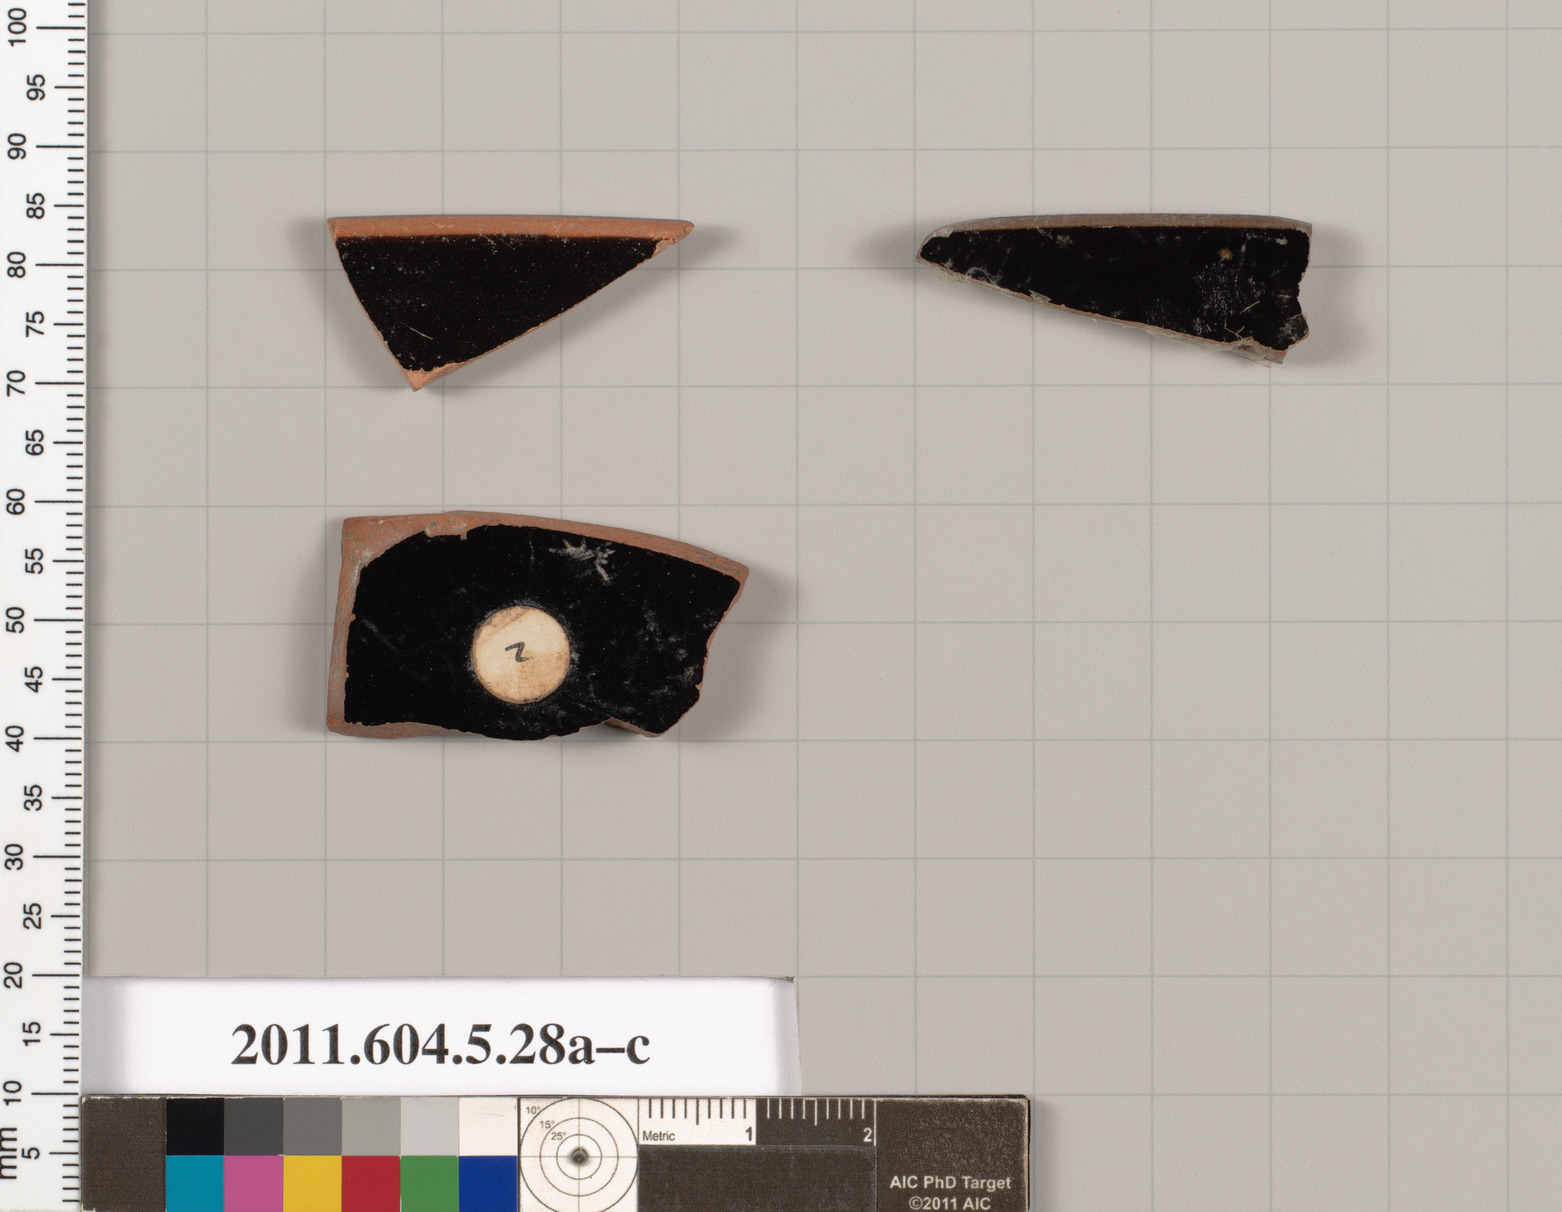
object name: kylix fragment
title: Terracotta fragments of kylikes (drinking cups)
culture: greek, attic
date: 475-451 BCE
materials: terracotta